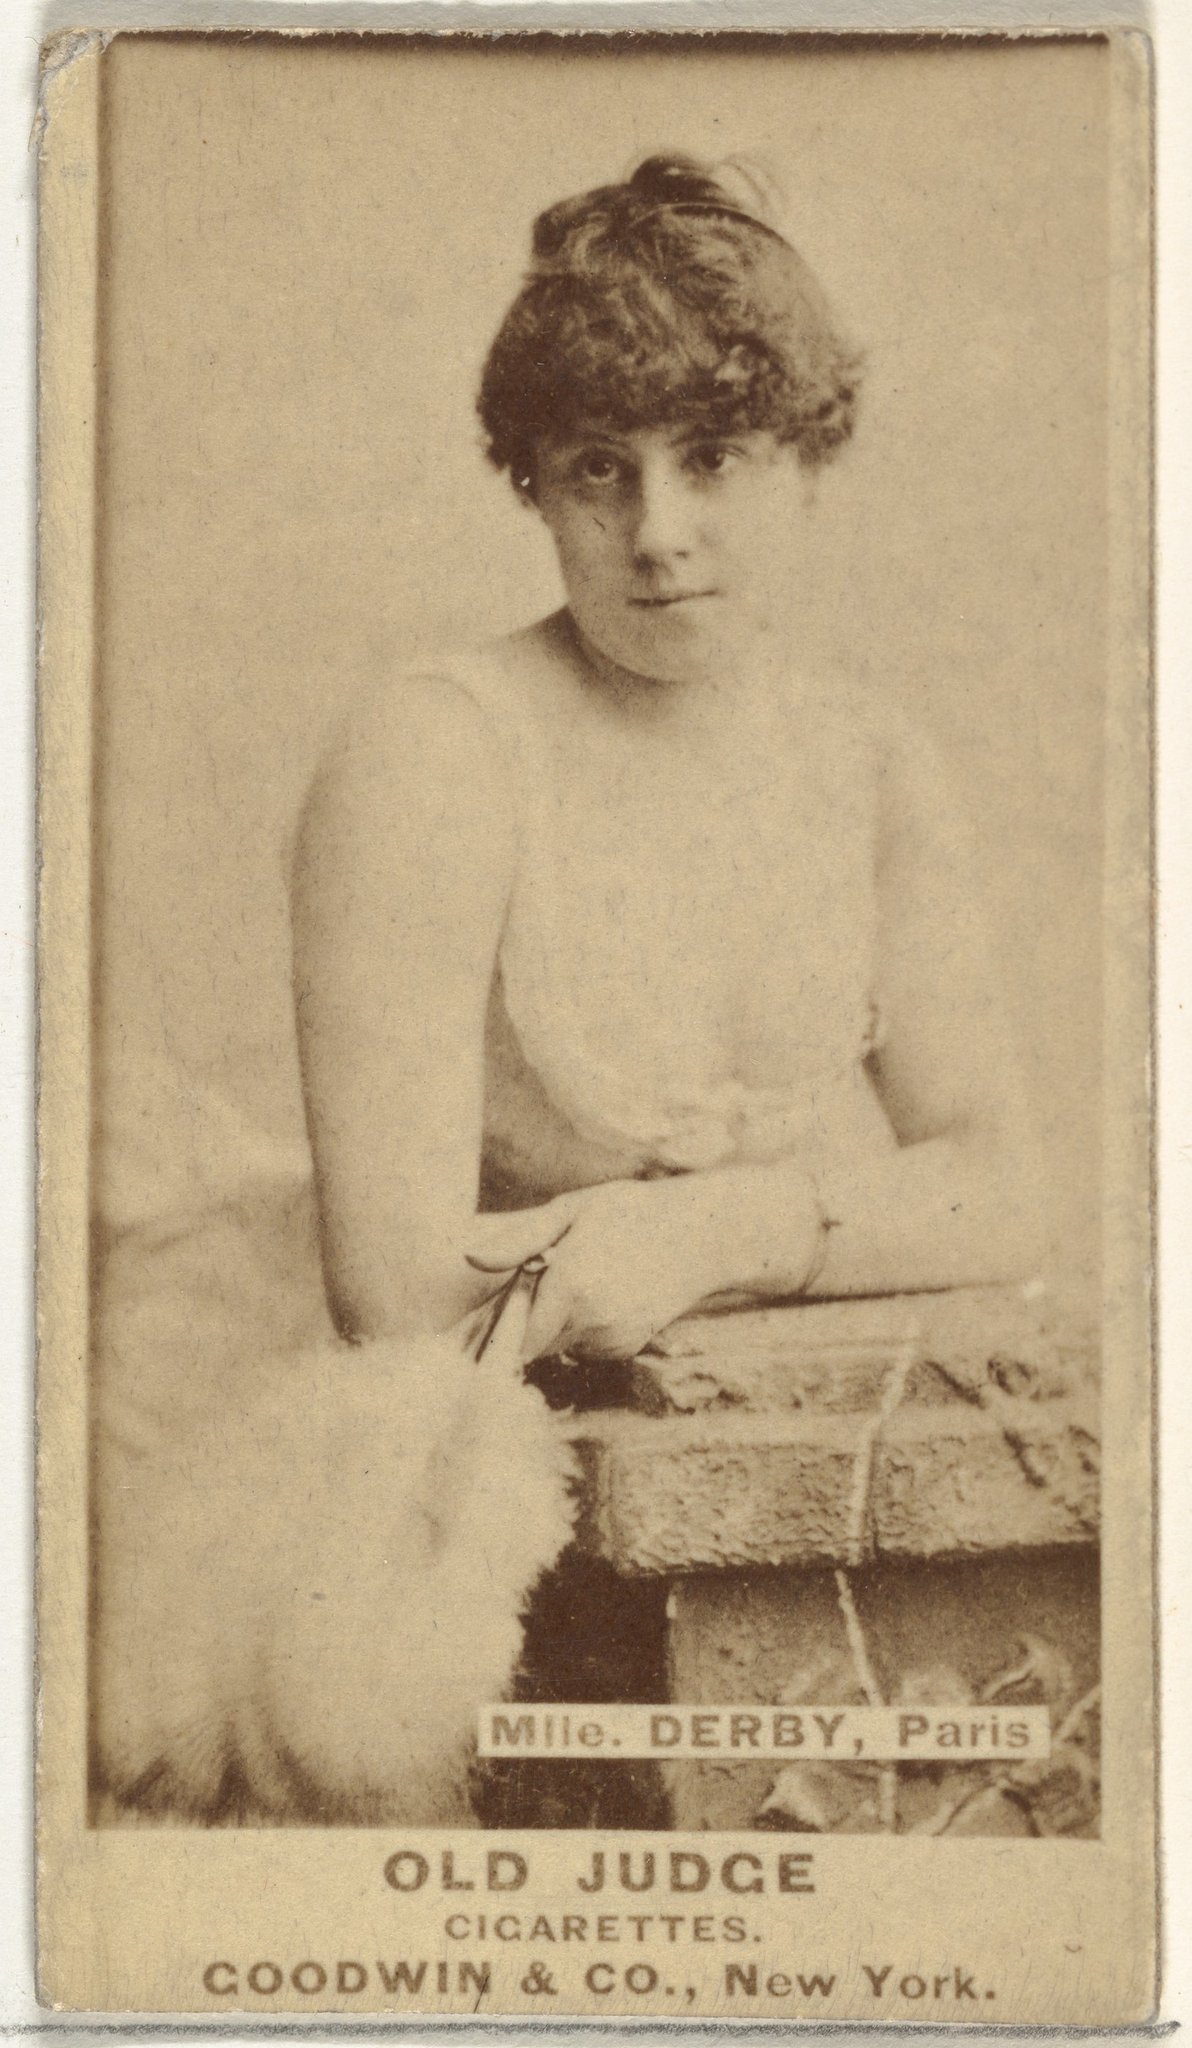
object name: photograph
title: Mlle. Derby, Paris, from the Actors and Actresses series (N171) for Old Judge Cigarettes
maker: goodwin & company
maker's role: publisher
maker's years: 1850-1950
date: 1886-1890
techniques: albumen silver print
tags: portraits,women,actresses